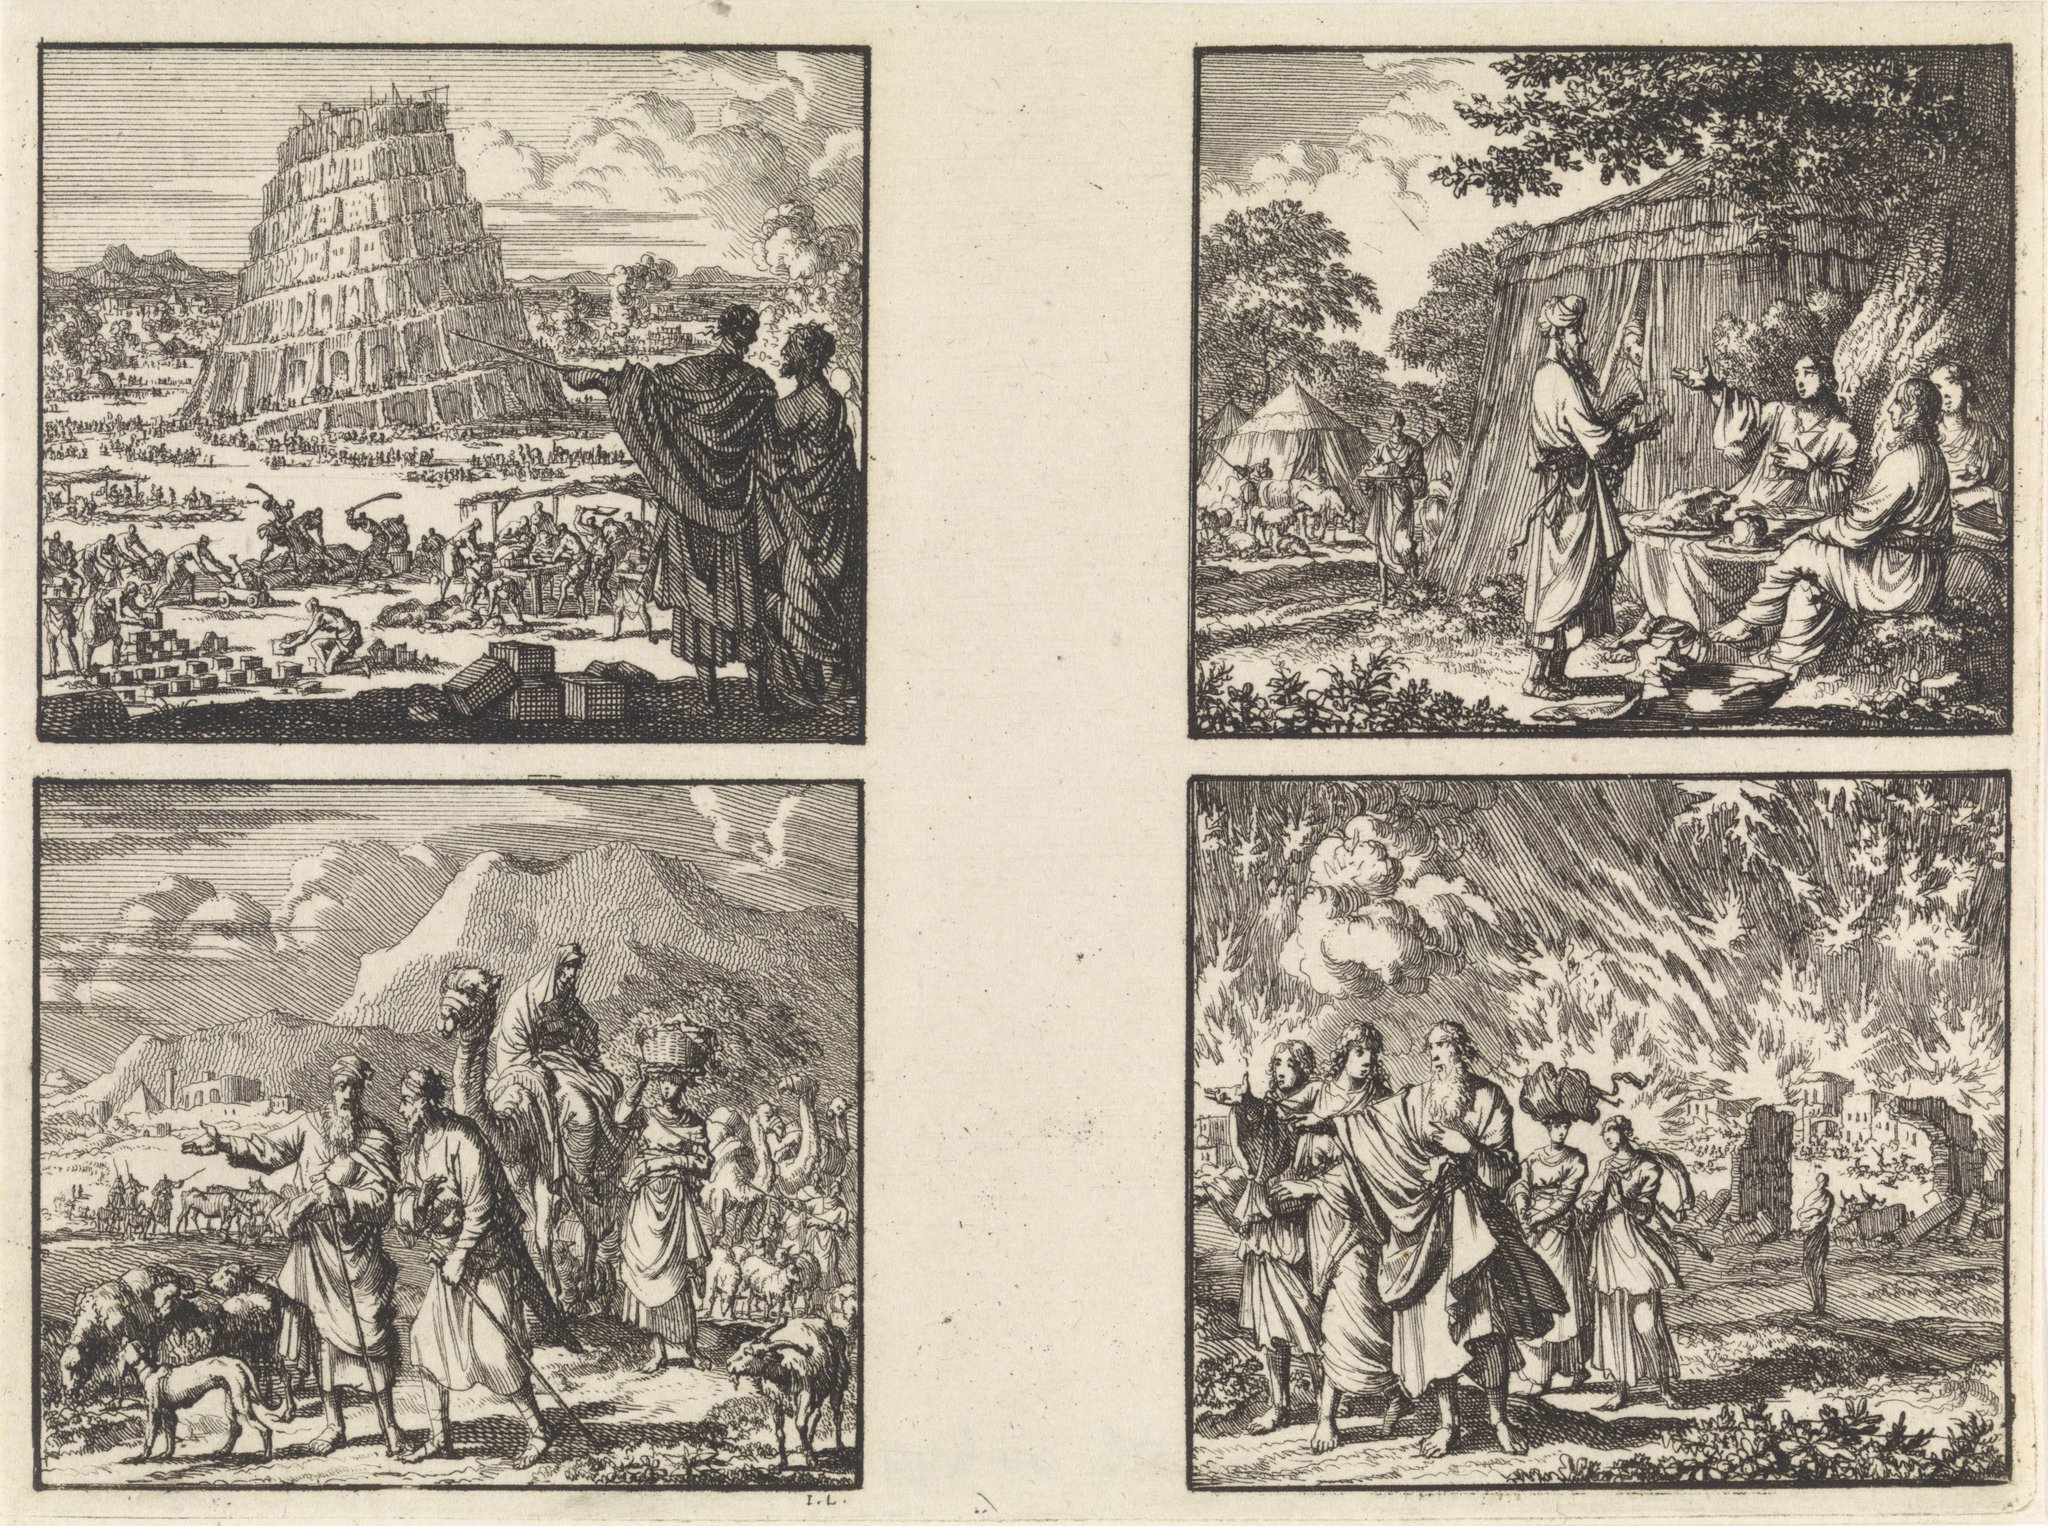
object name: print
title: Bouw van de Toren van Babel / Abraham en Lot verlaten hun vaderland / Abraham ontvangt de drie engelen / Lot verlaat Sodom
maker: jan luyken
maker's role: draughtsman, print maker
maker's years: 1649-1712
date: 1698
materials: paper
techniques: etching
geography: amsterdam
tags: the building of the tower of babel; nimrod may be present, supervising or assisting the construction, abraham leaves egypt with sarah, lot, and his possessions, the visit of the three angels (three men) ~ story of abraham (genesis 18), the destruction of sodom and gomorrah: lot and his family flee to zoar, carrying their belongings; an angel may be showing the way (genesis 19:24-29)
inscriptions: collector's mark: Lugt 2228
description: Proefdruk van illustraties uit: Josephus, Flavius. XX. boeken van de oude geschiedenissen der joden, 4 delen. Amsterdam: Barent Visscher, Willem de Coup, Willem van Lamsveld, Andries van Damme, 1698, dl. I.